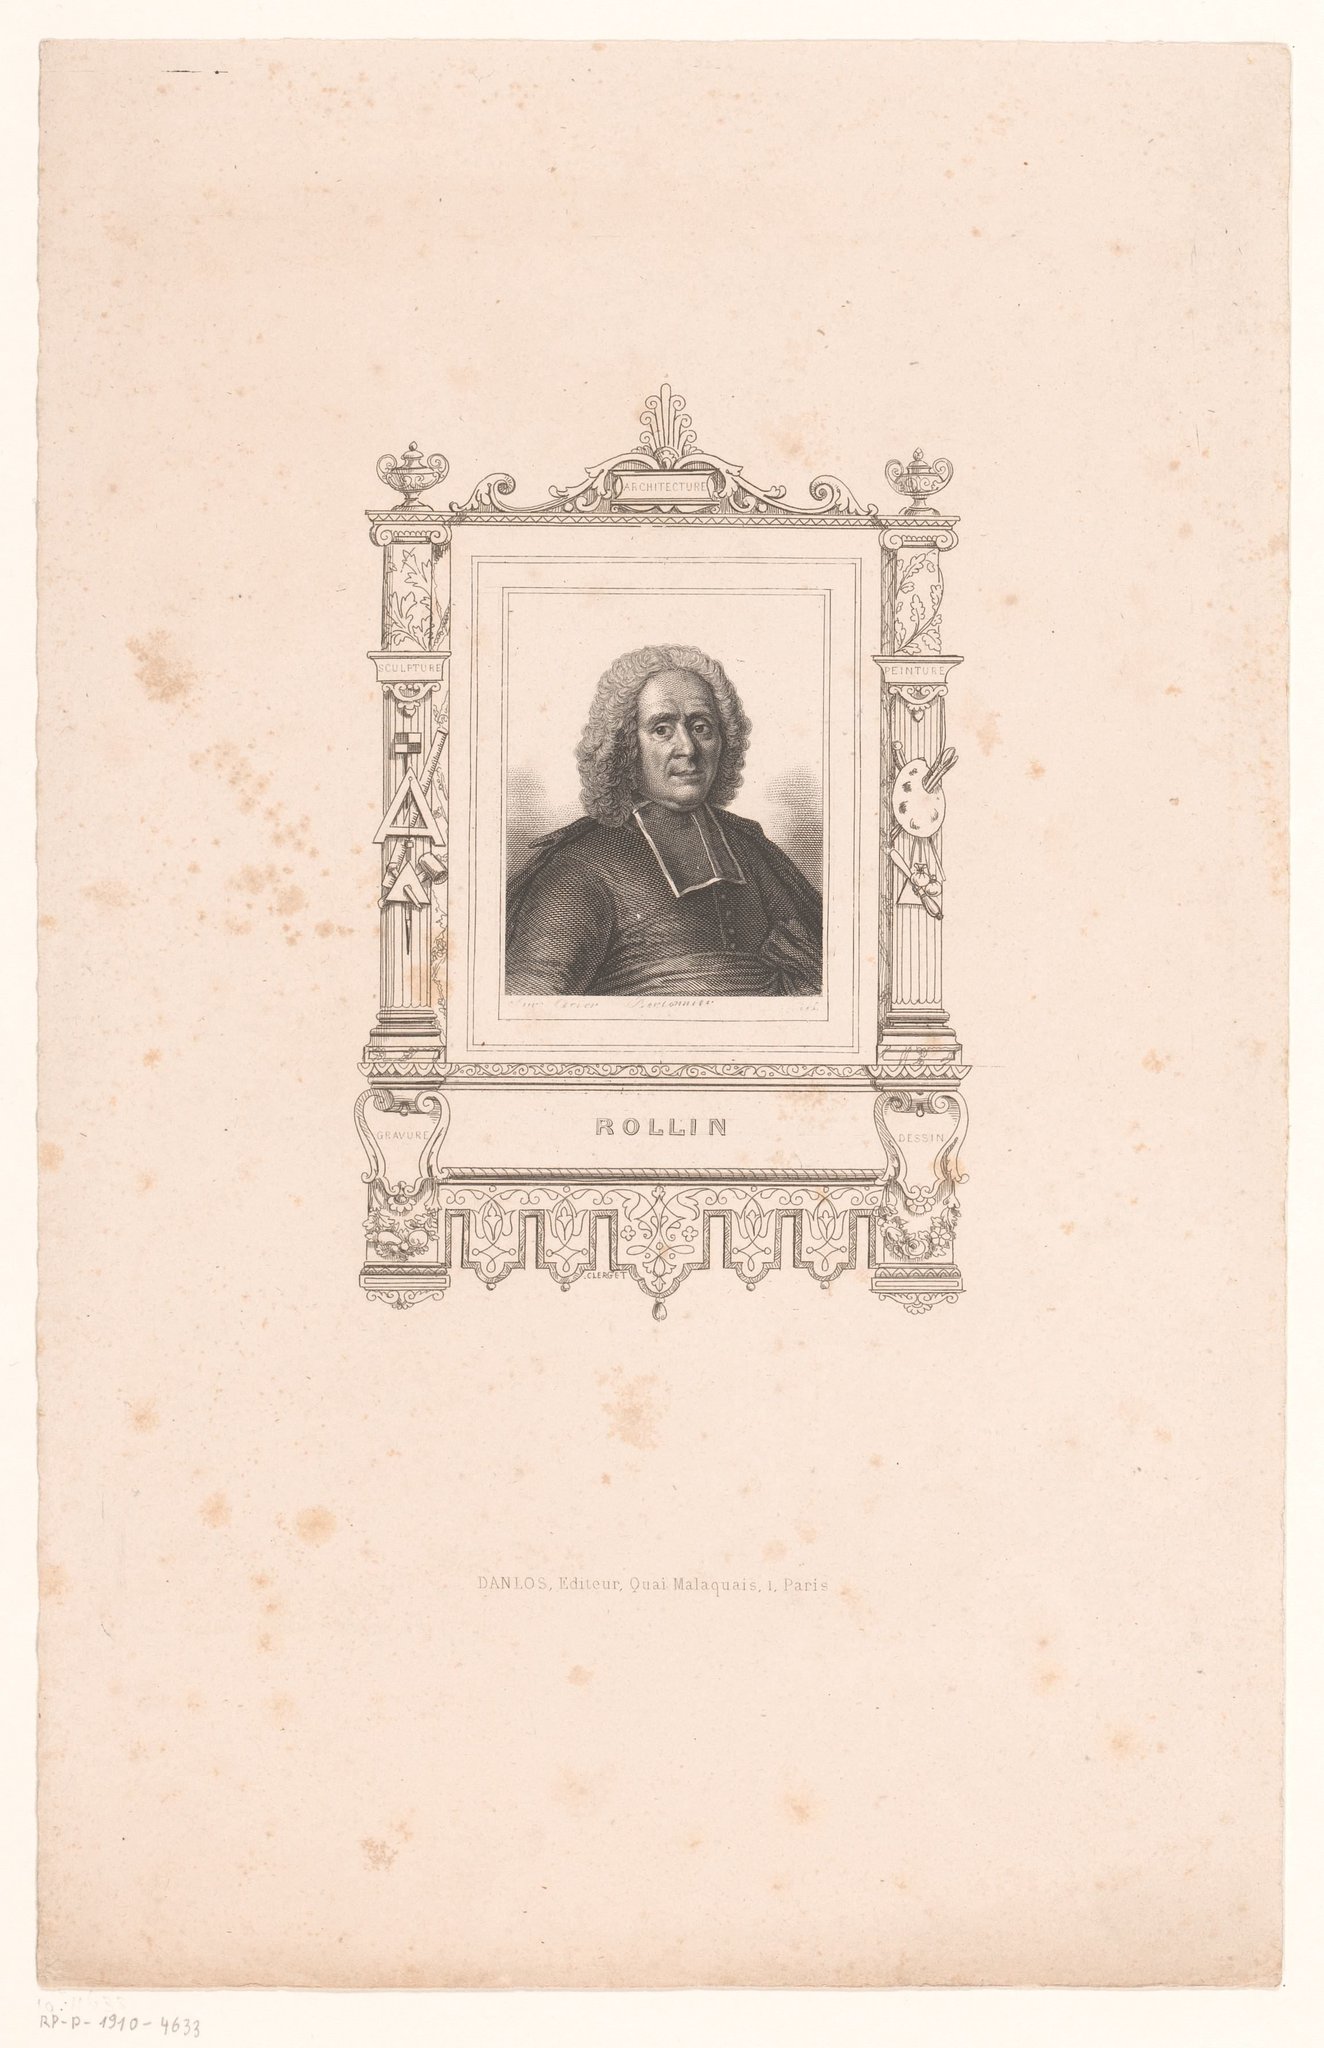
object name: print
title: Portret van Chales Rollin in een versierde cartouche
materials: paper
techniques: etching, engraving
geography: france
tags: paris, charles rollin, historical persons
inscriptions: collector's mark: Lugt 2228